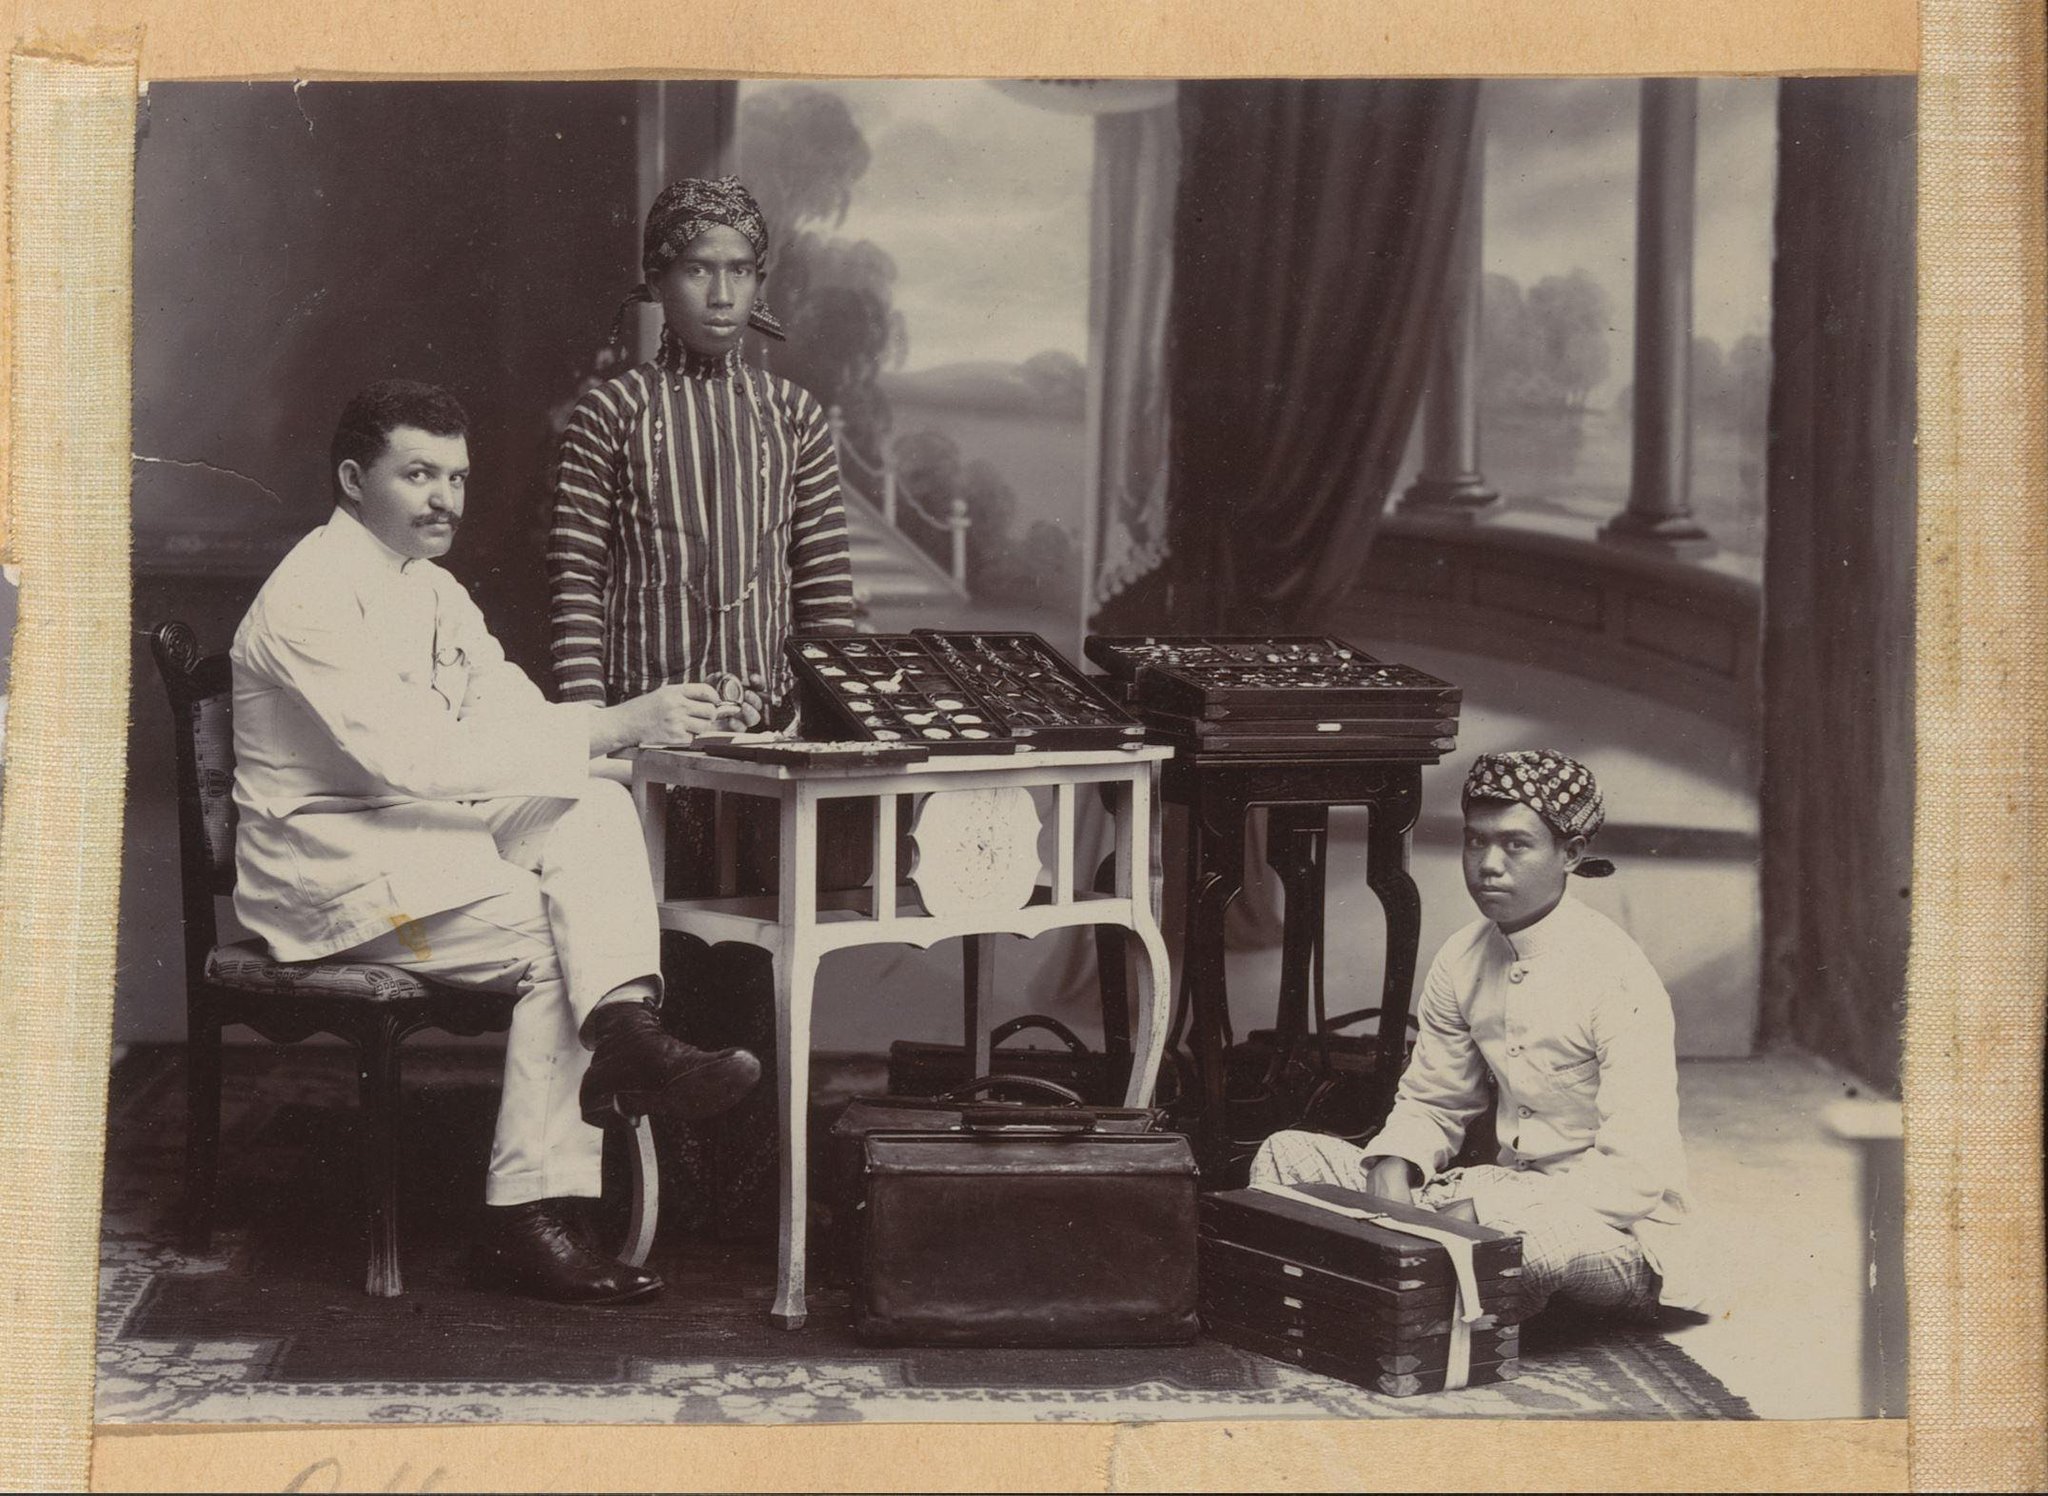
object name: photograph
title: Groepsportret van een Europese man aangeduid als Delberg en twee Indische sieradenverkopers, vermoedelijk in fotostudio Gah Hien in Jogyakarta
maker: gah hien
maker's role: fotograaf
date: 1916-1918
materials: photographic support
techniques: gelatin silver print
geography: jogjakarta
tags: studio requisites ~ photographer, official; civil servant; functionary (in general), wandering or travelling merchant, dutch east indies, the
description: Onderdeel van Familiealbum met foto's van een familie in de voormalige kolonie Nederlands-Indië en van een suikerfabriek in Purworejo.